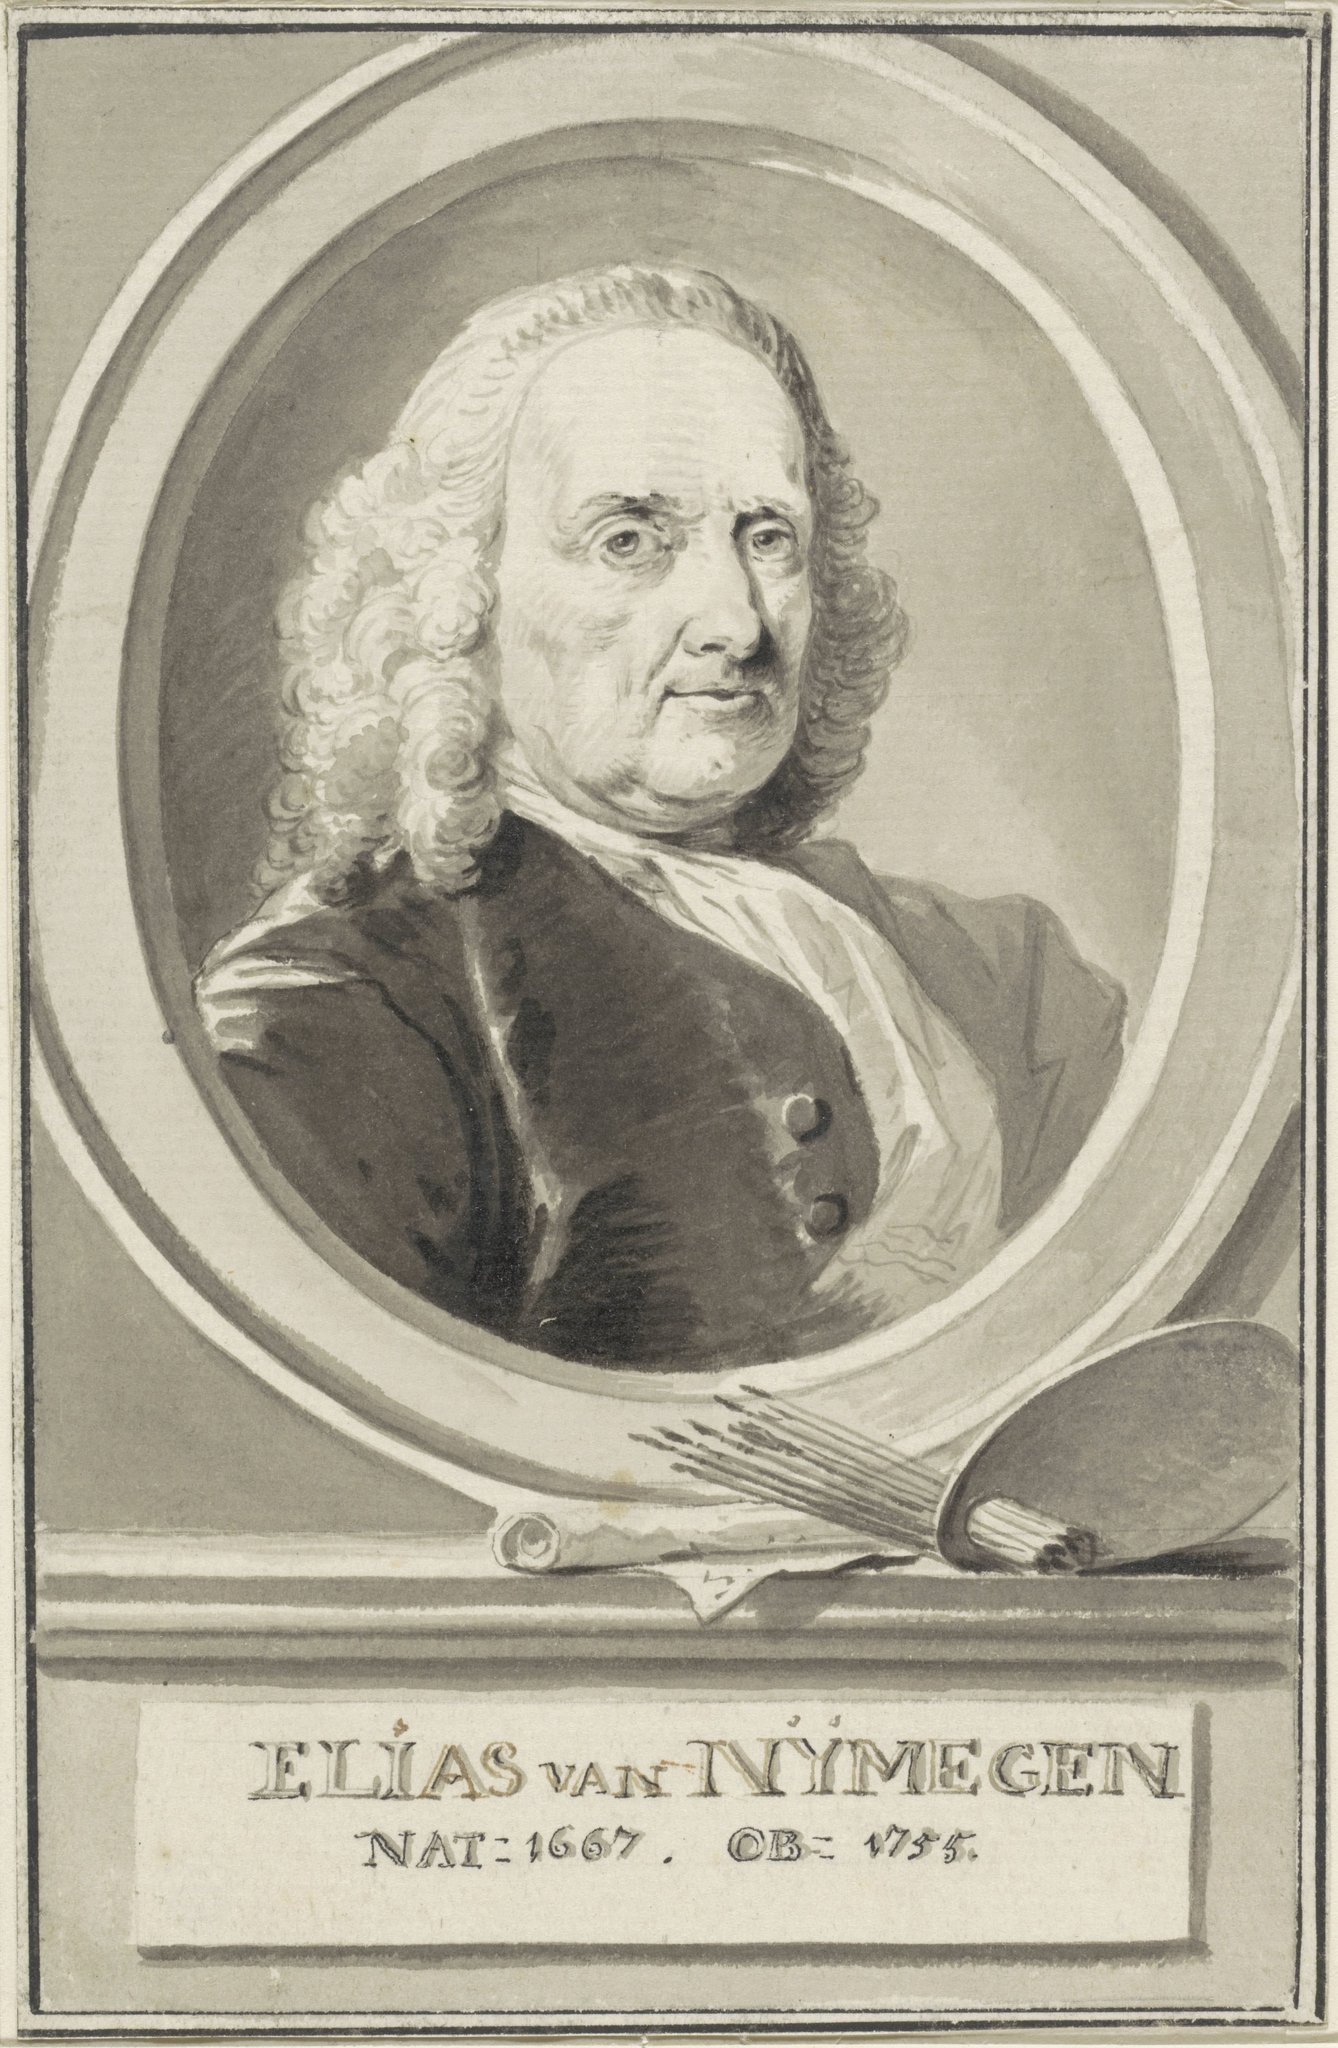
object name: drawing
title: Portret van Elias van Nijmegen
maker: aert schouman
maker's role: draughtsman, painter, print maker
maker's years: 1710-1792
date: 1720-1792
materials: paper, pencil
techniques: brush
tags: nijmegen, rotterdam, painter, draughtsman, elias van nijmegen, historical persons, portrait, self-portrait of artist